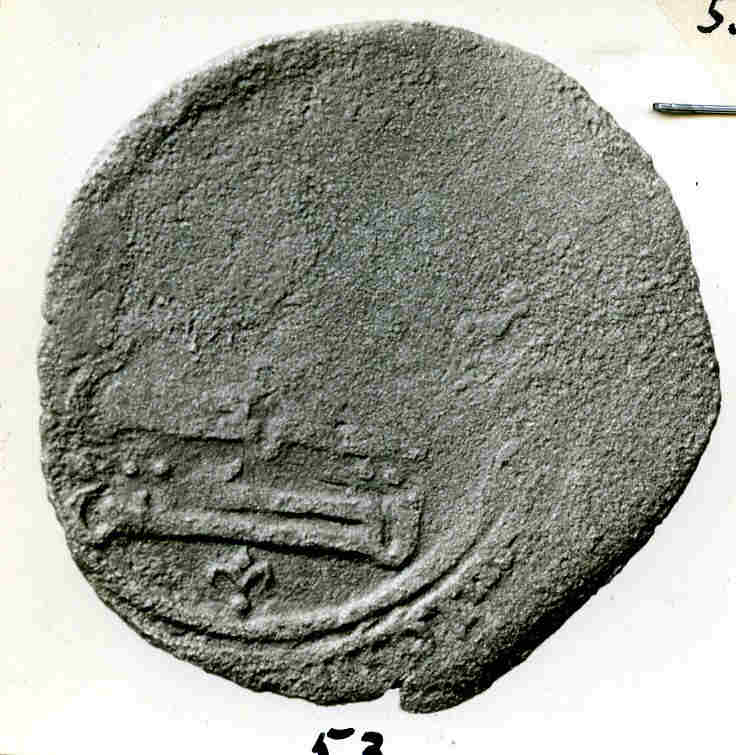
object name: coin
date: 1067-1233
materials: copper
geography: iran